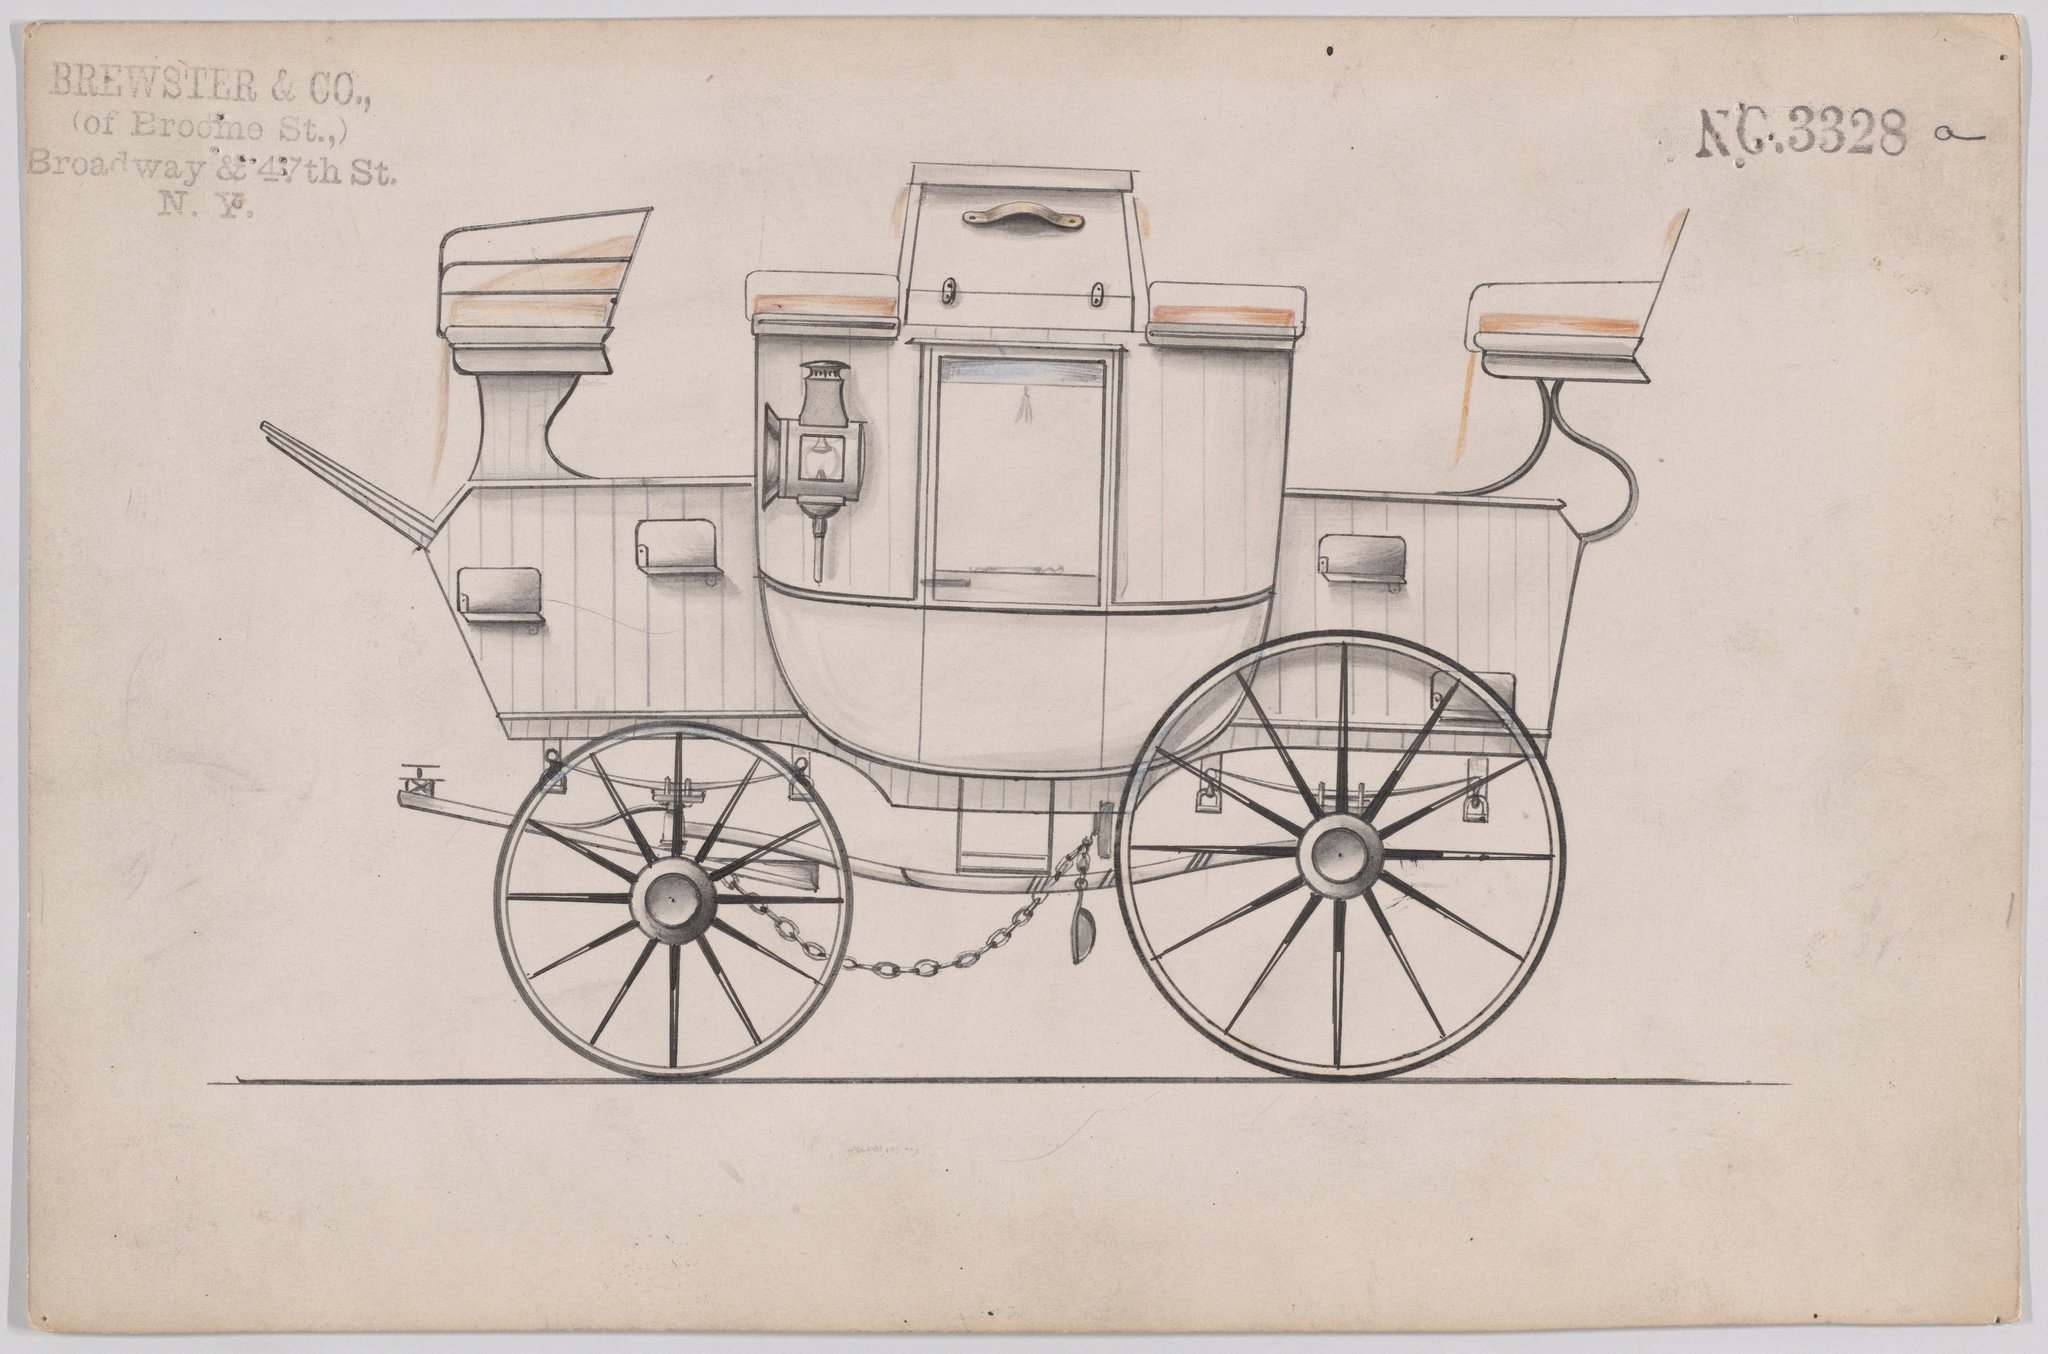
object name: drawing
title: Park Drag #3328a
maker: brewster & co.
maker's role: manufacturer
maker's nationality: american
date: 1877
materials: gouache, graphite, ink, watercolor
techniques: pen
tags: carriages